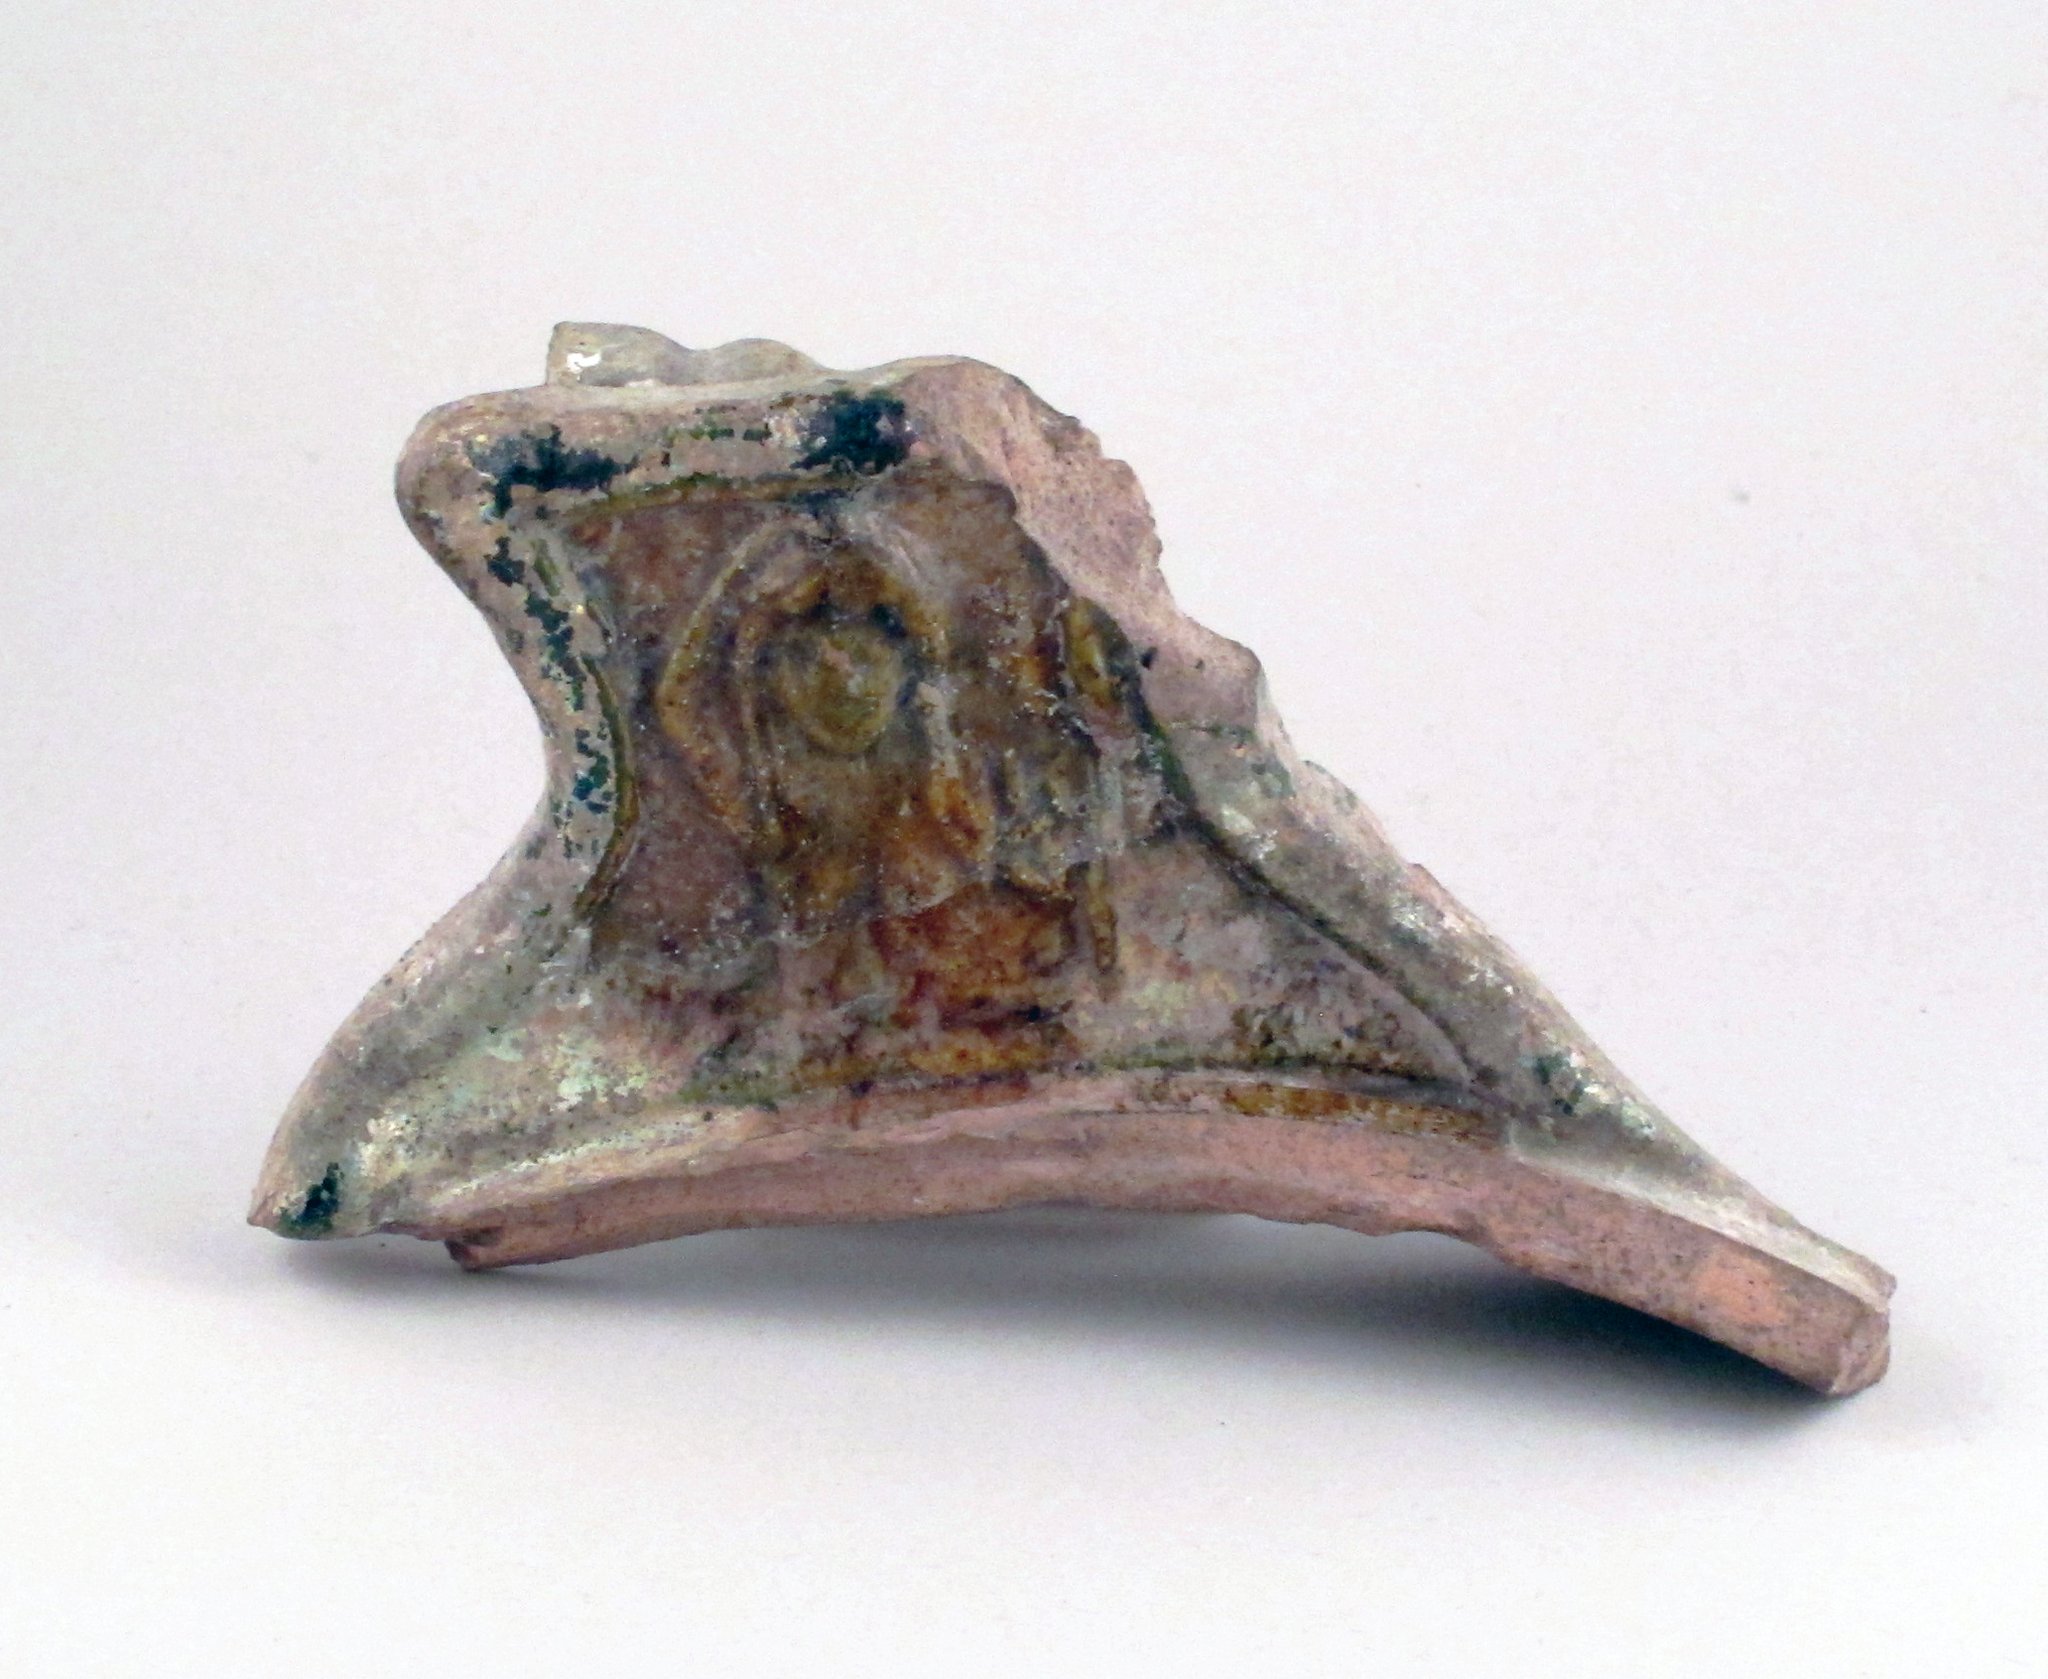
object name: vase fragment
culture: roman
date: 670 BCE-330 CE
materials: terracotta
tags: women